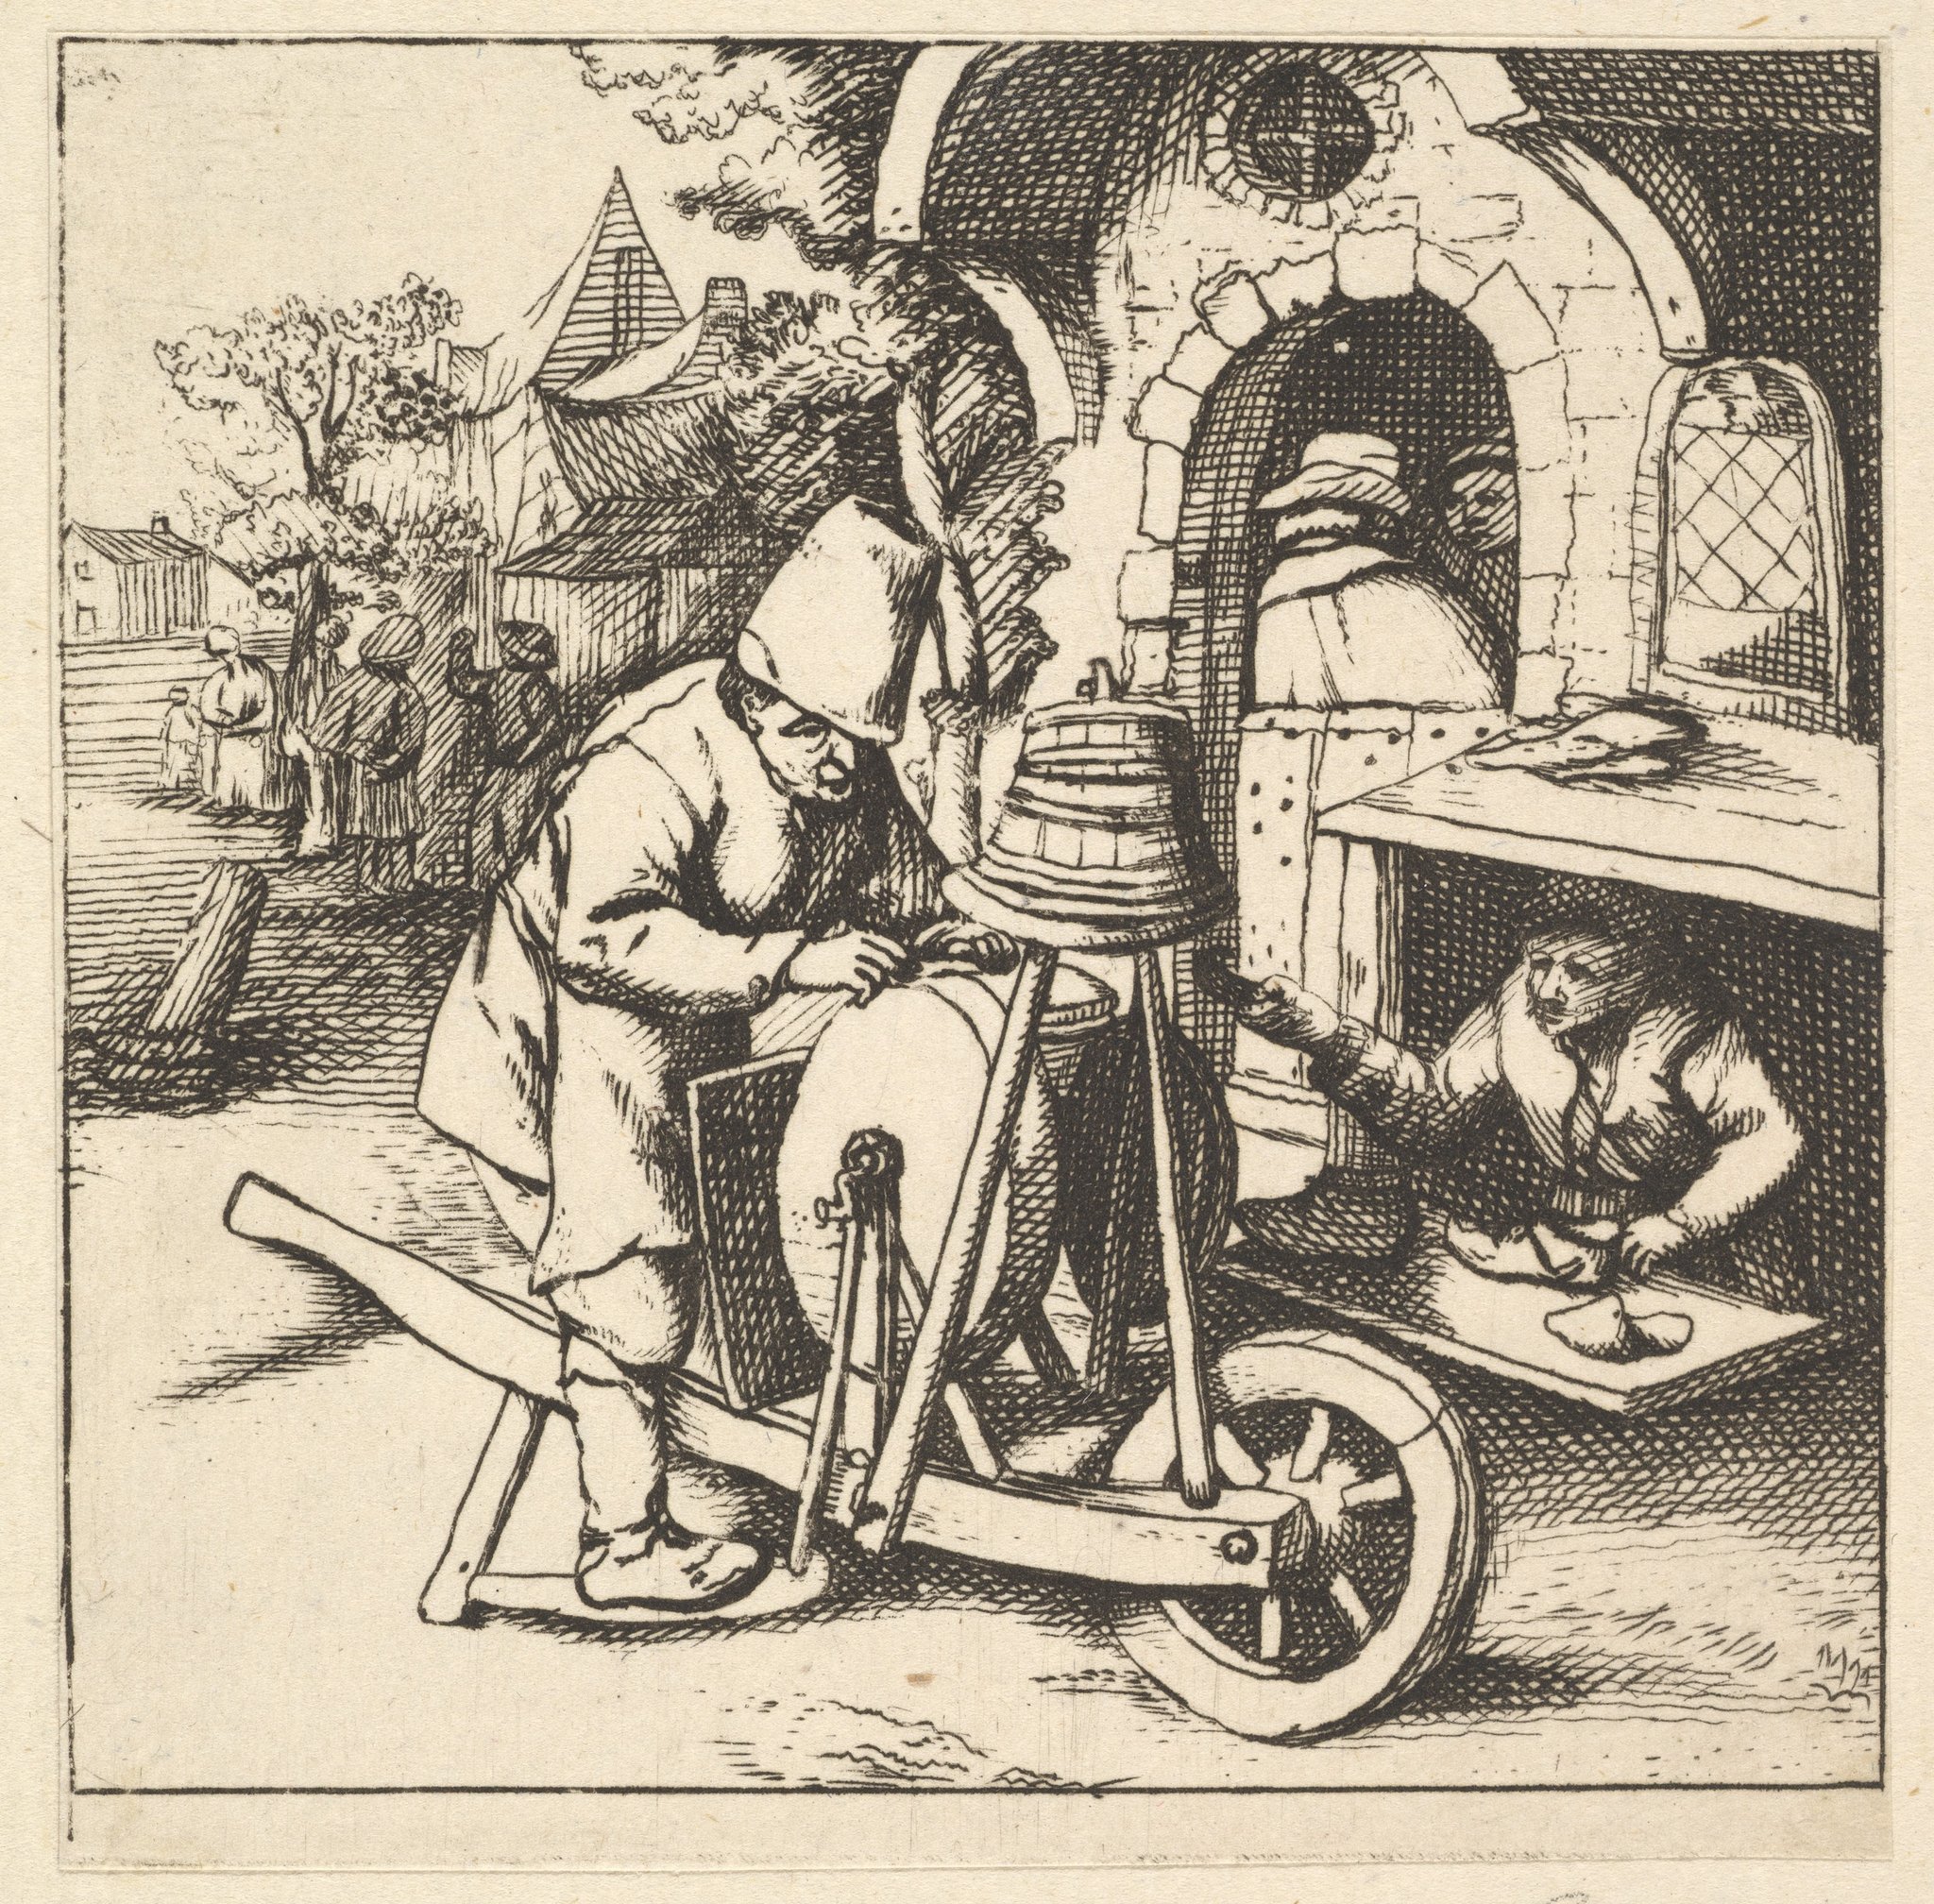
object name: print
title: The Knifegrinder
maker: adriaen van ostade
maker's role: artist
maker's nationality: dutch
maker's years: 1610-1685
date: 1610-1685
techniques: etching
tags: men,working